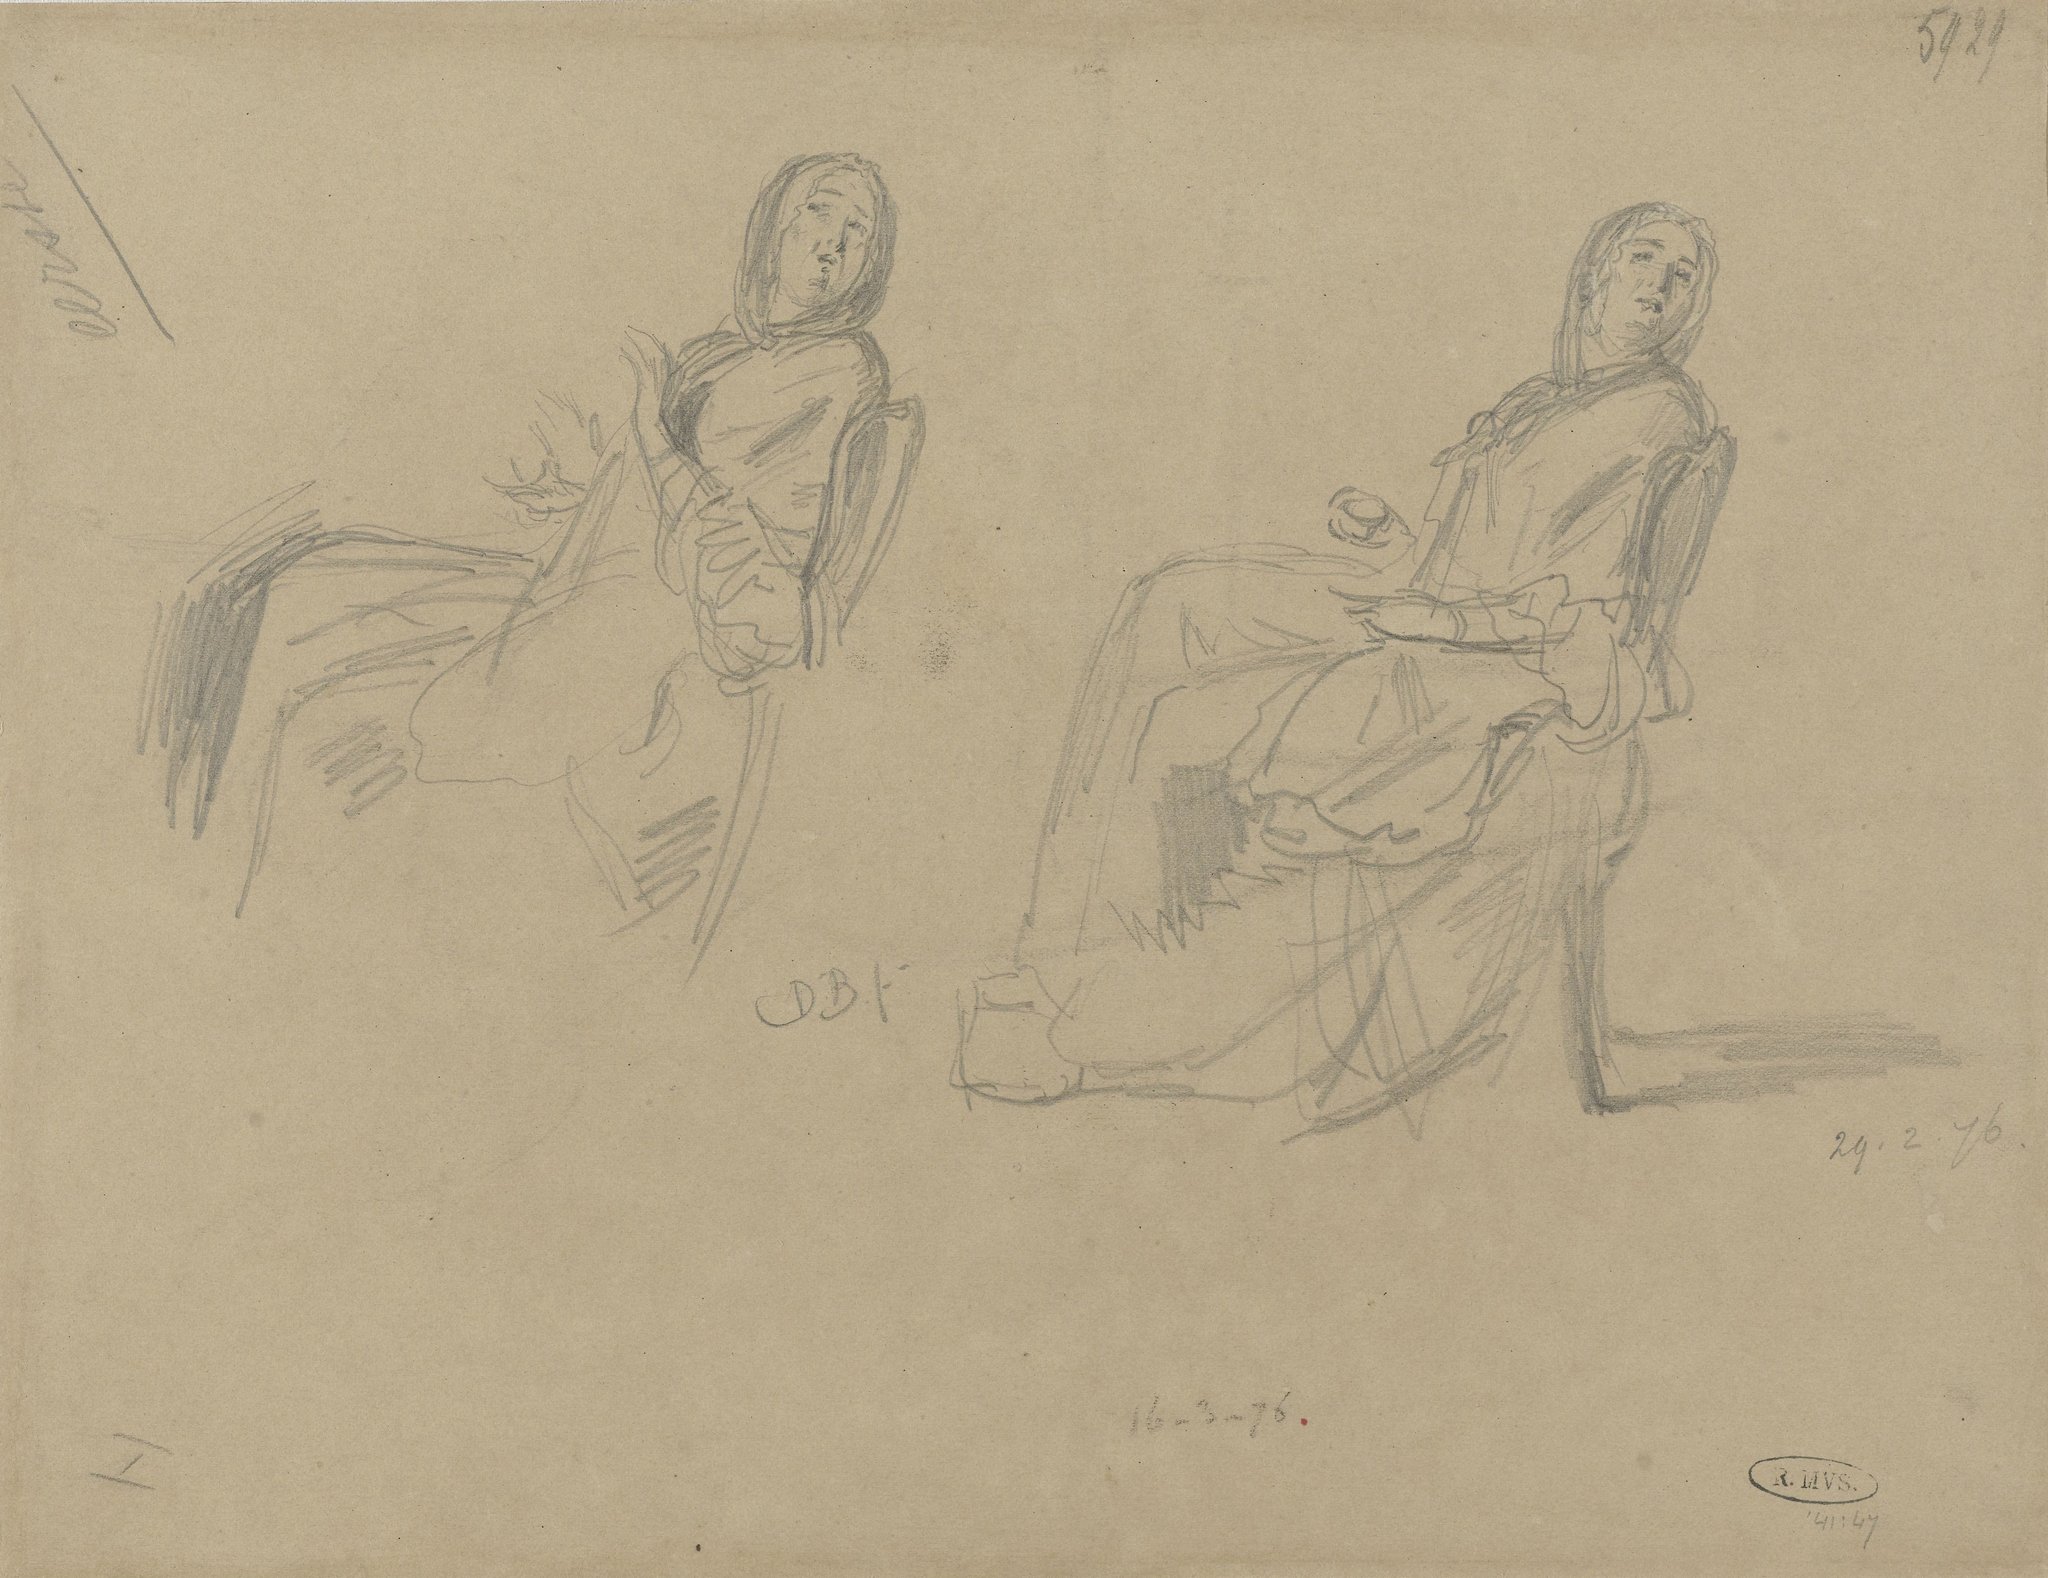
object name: drawing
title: Twee studies van een zittende vrouw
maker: david bles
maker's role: draughtsman, painter, print maker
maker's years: 1821-1899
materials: paper, pencil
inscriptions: date